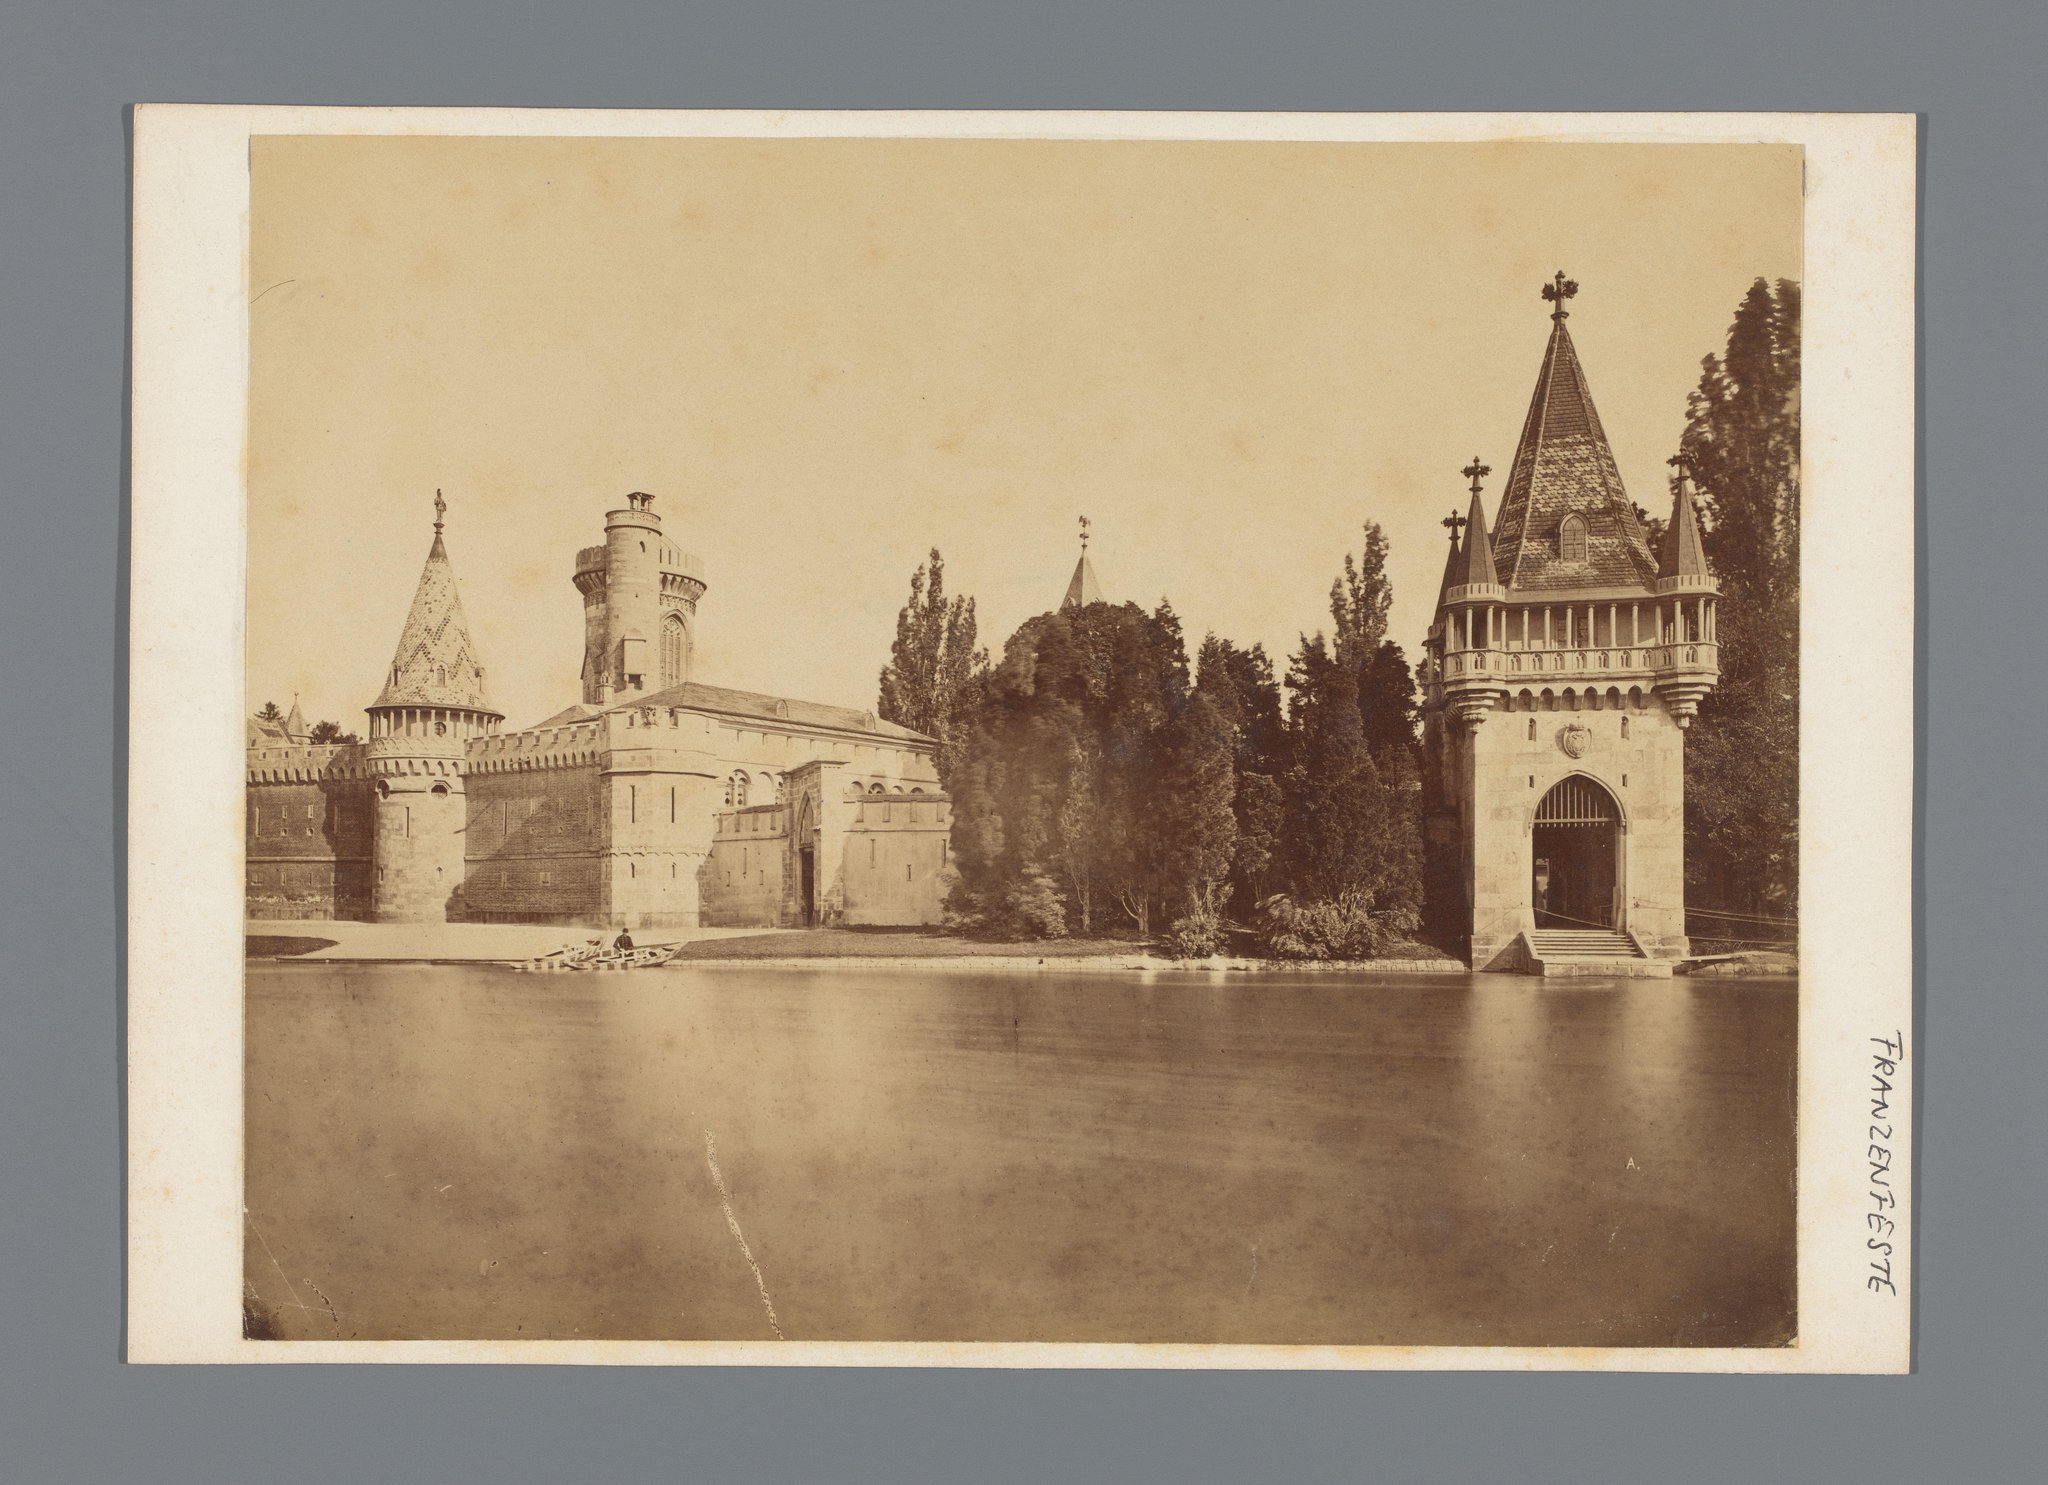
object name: photograph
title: Franzenfeste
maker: Anonymous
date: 1850-1900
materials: cardboard, photographic support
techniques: albumen print